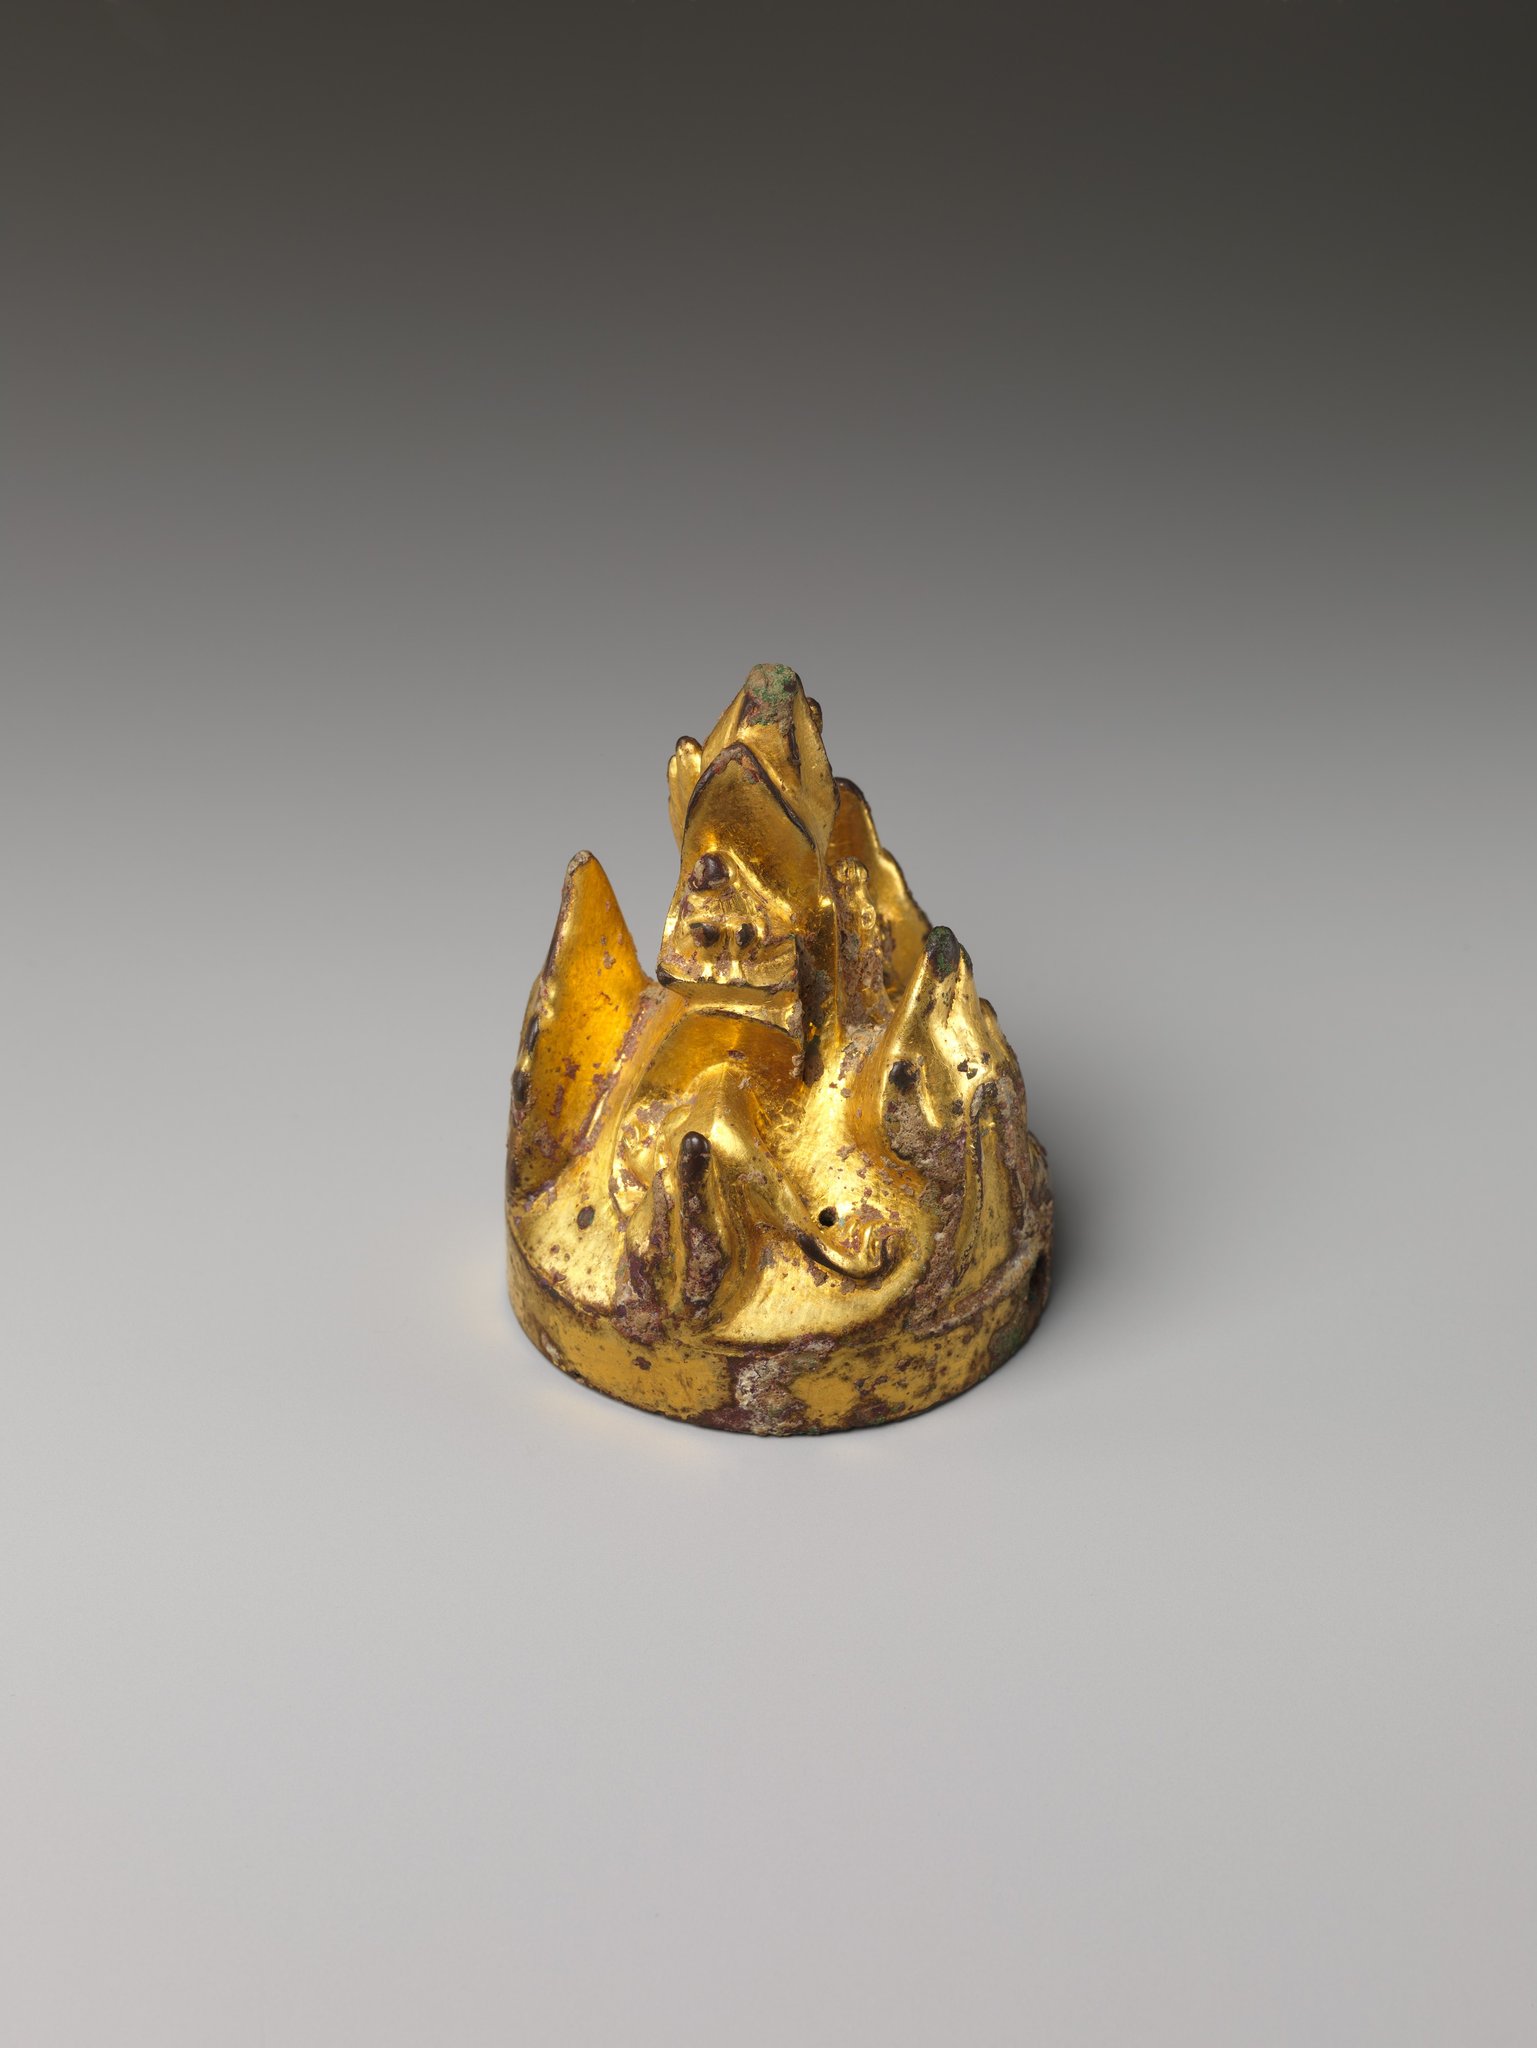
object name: ornament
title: Top of a bridge pin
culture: chinese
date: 200-1 BCE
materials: gilt bronze